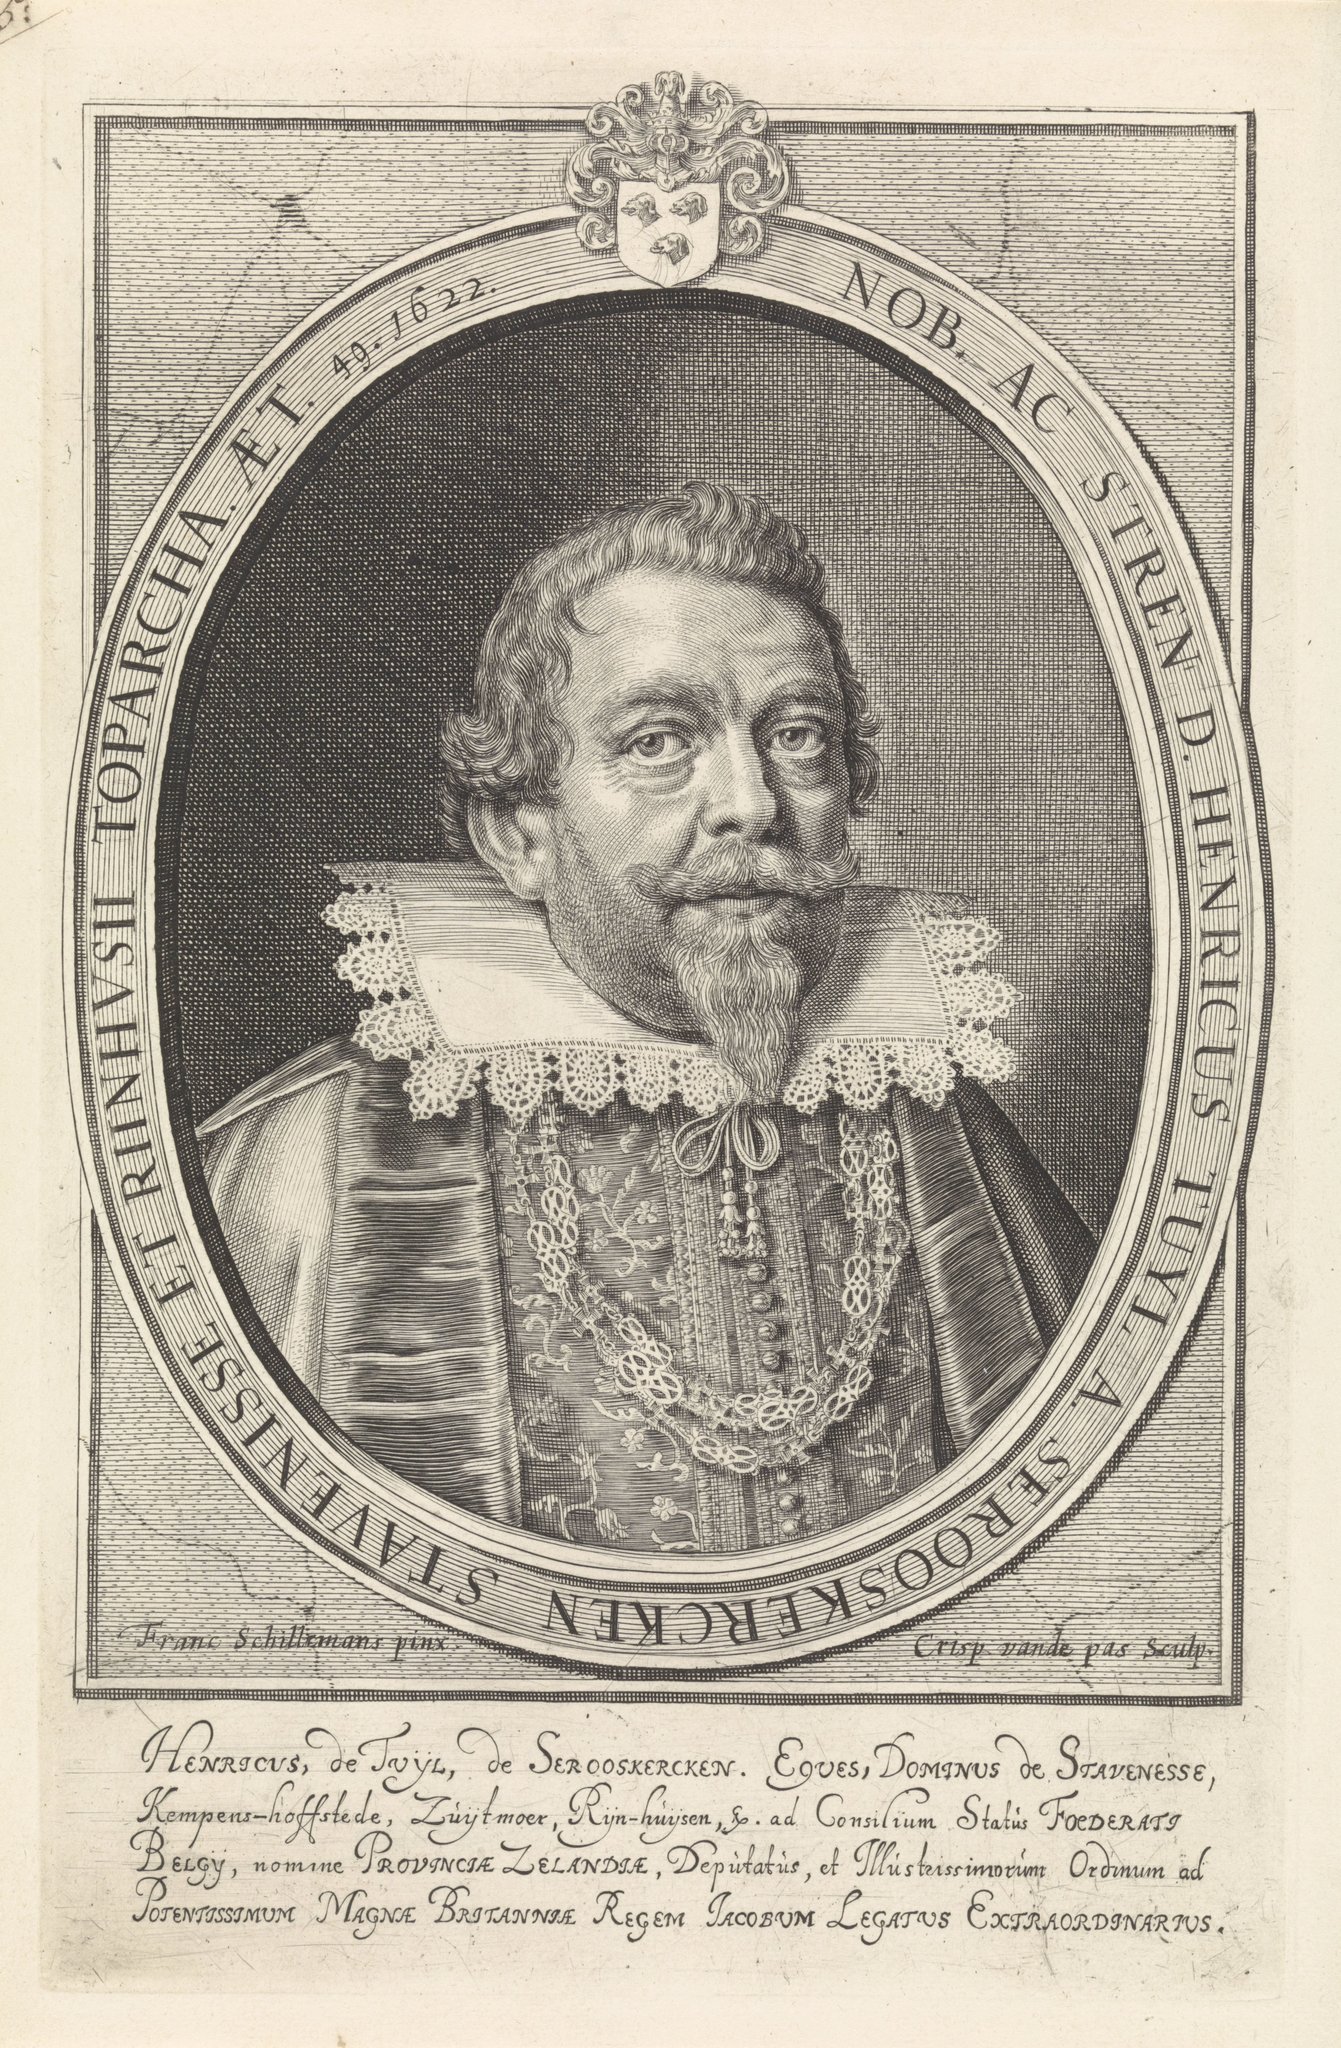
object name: print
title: Portret van Hendrik van Tuyll van Serooskerken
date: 1622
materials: paper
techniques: engraving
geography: utrecht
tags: lierre, the hague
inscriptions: collector's mark: Lugt 2228, number: ‘5’, number: ‘114’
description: Portret van Hendrik van Tuyll van Serooskerken, op 49-jarige leeftijd. Hij was heer van Stavernisse in Zeeland en van Rijnhuizen in Utrecht en buitengewoon gezant aan het hof van Groot-Brittannië en gedeputeerde in de Raad van State. In de marge een vierregelig onderschrift met de naam en functies van de geportretteerde in het Latijn.